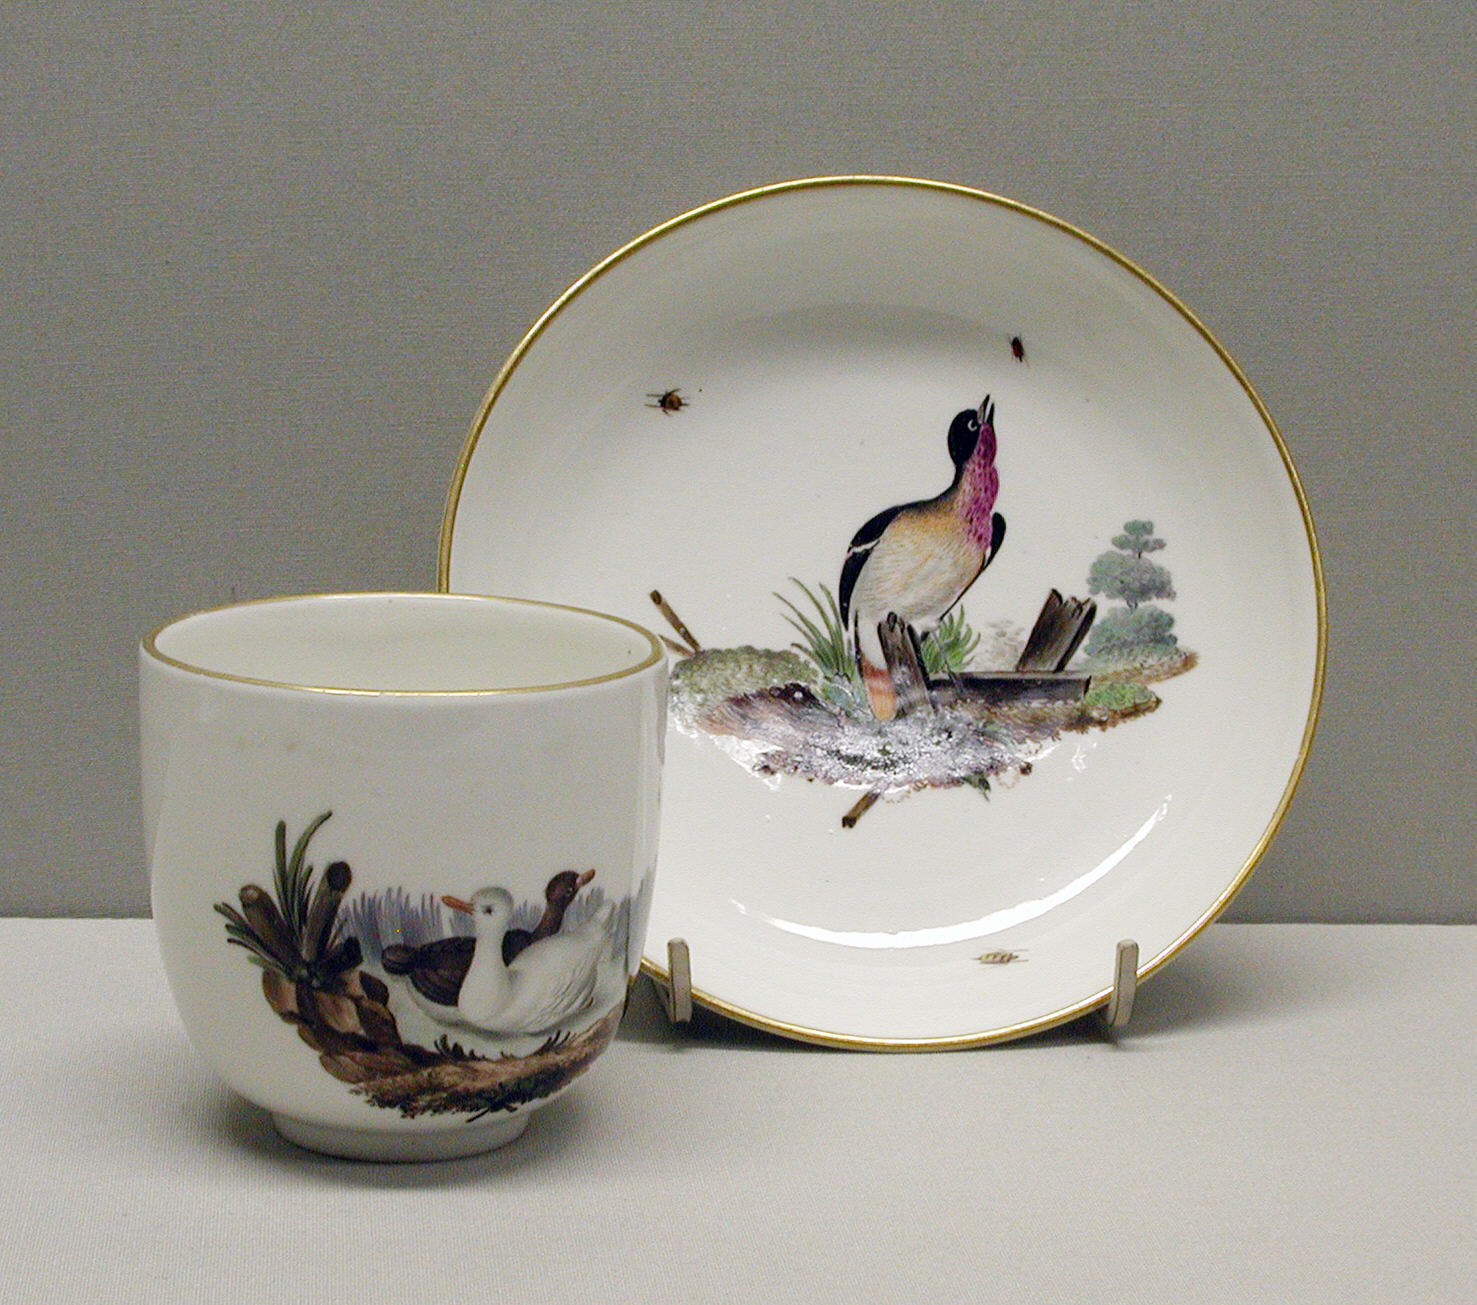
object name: cup and saucer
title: Coffee cup and saucer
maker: höchst manufactory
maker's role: manufactory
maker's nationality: german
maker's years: 1746-1796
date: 1775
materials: hard paste porcelain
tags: birds,ducks